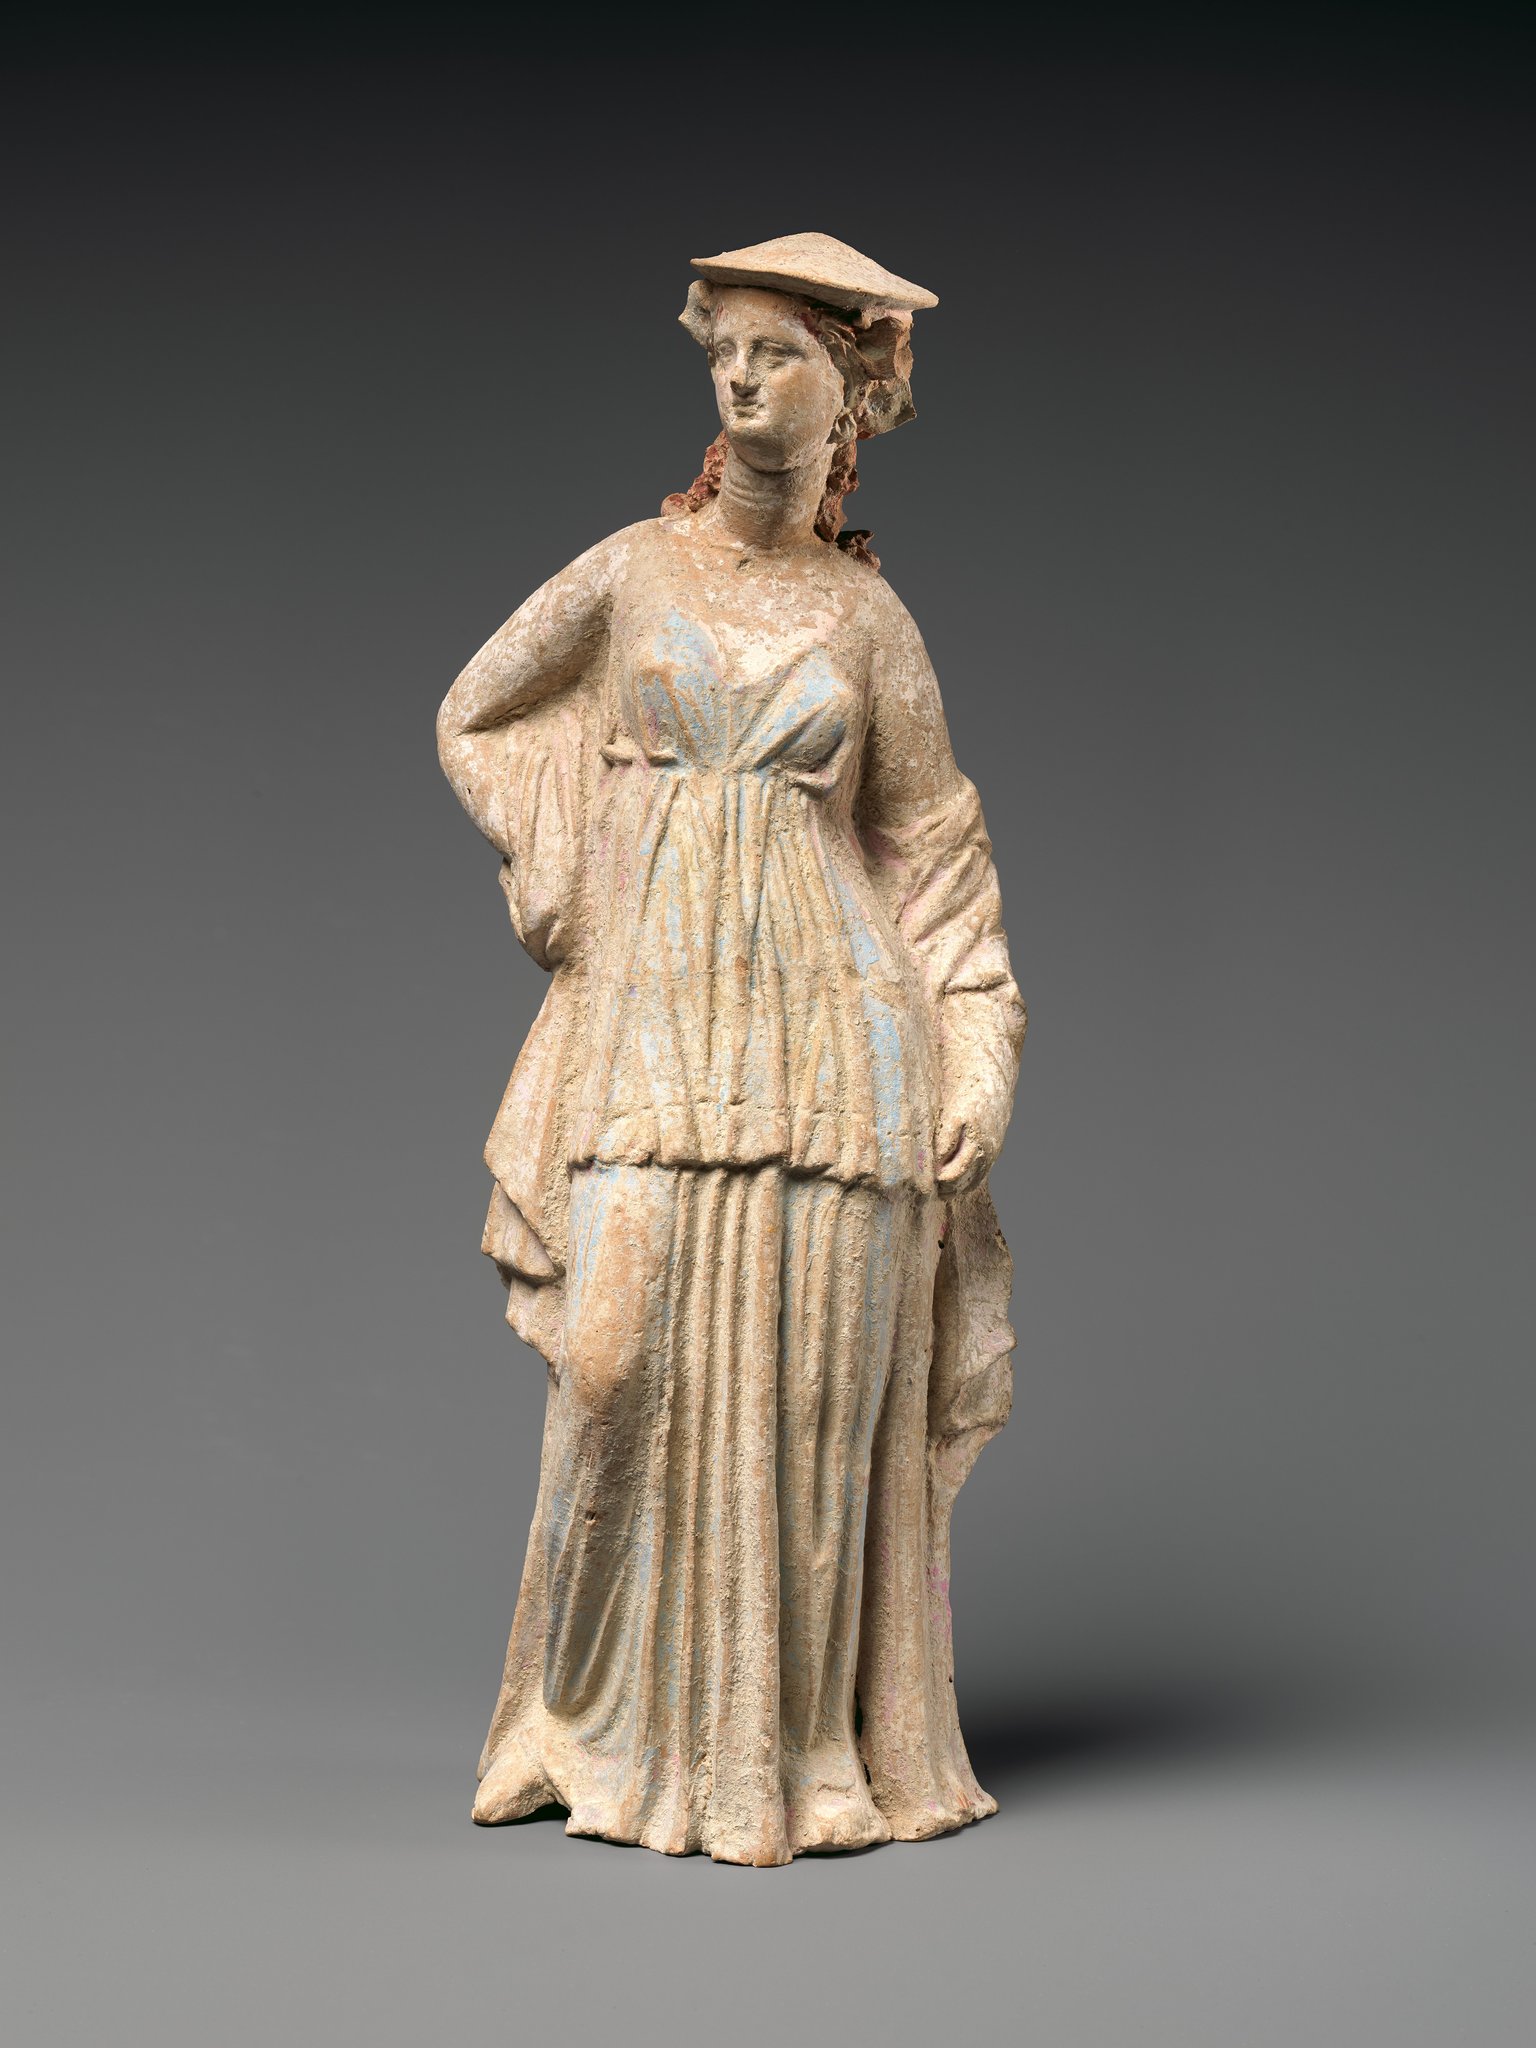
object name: statuette of a woman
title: Terracotta statuette of a woman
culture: greek, south italian, tarentine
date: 300-268 BCE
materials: terracotta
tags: women